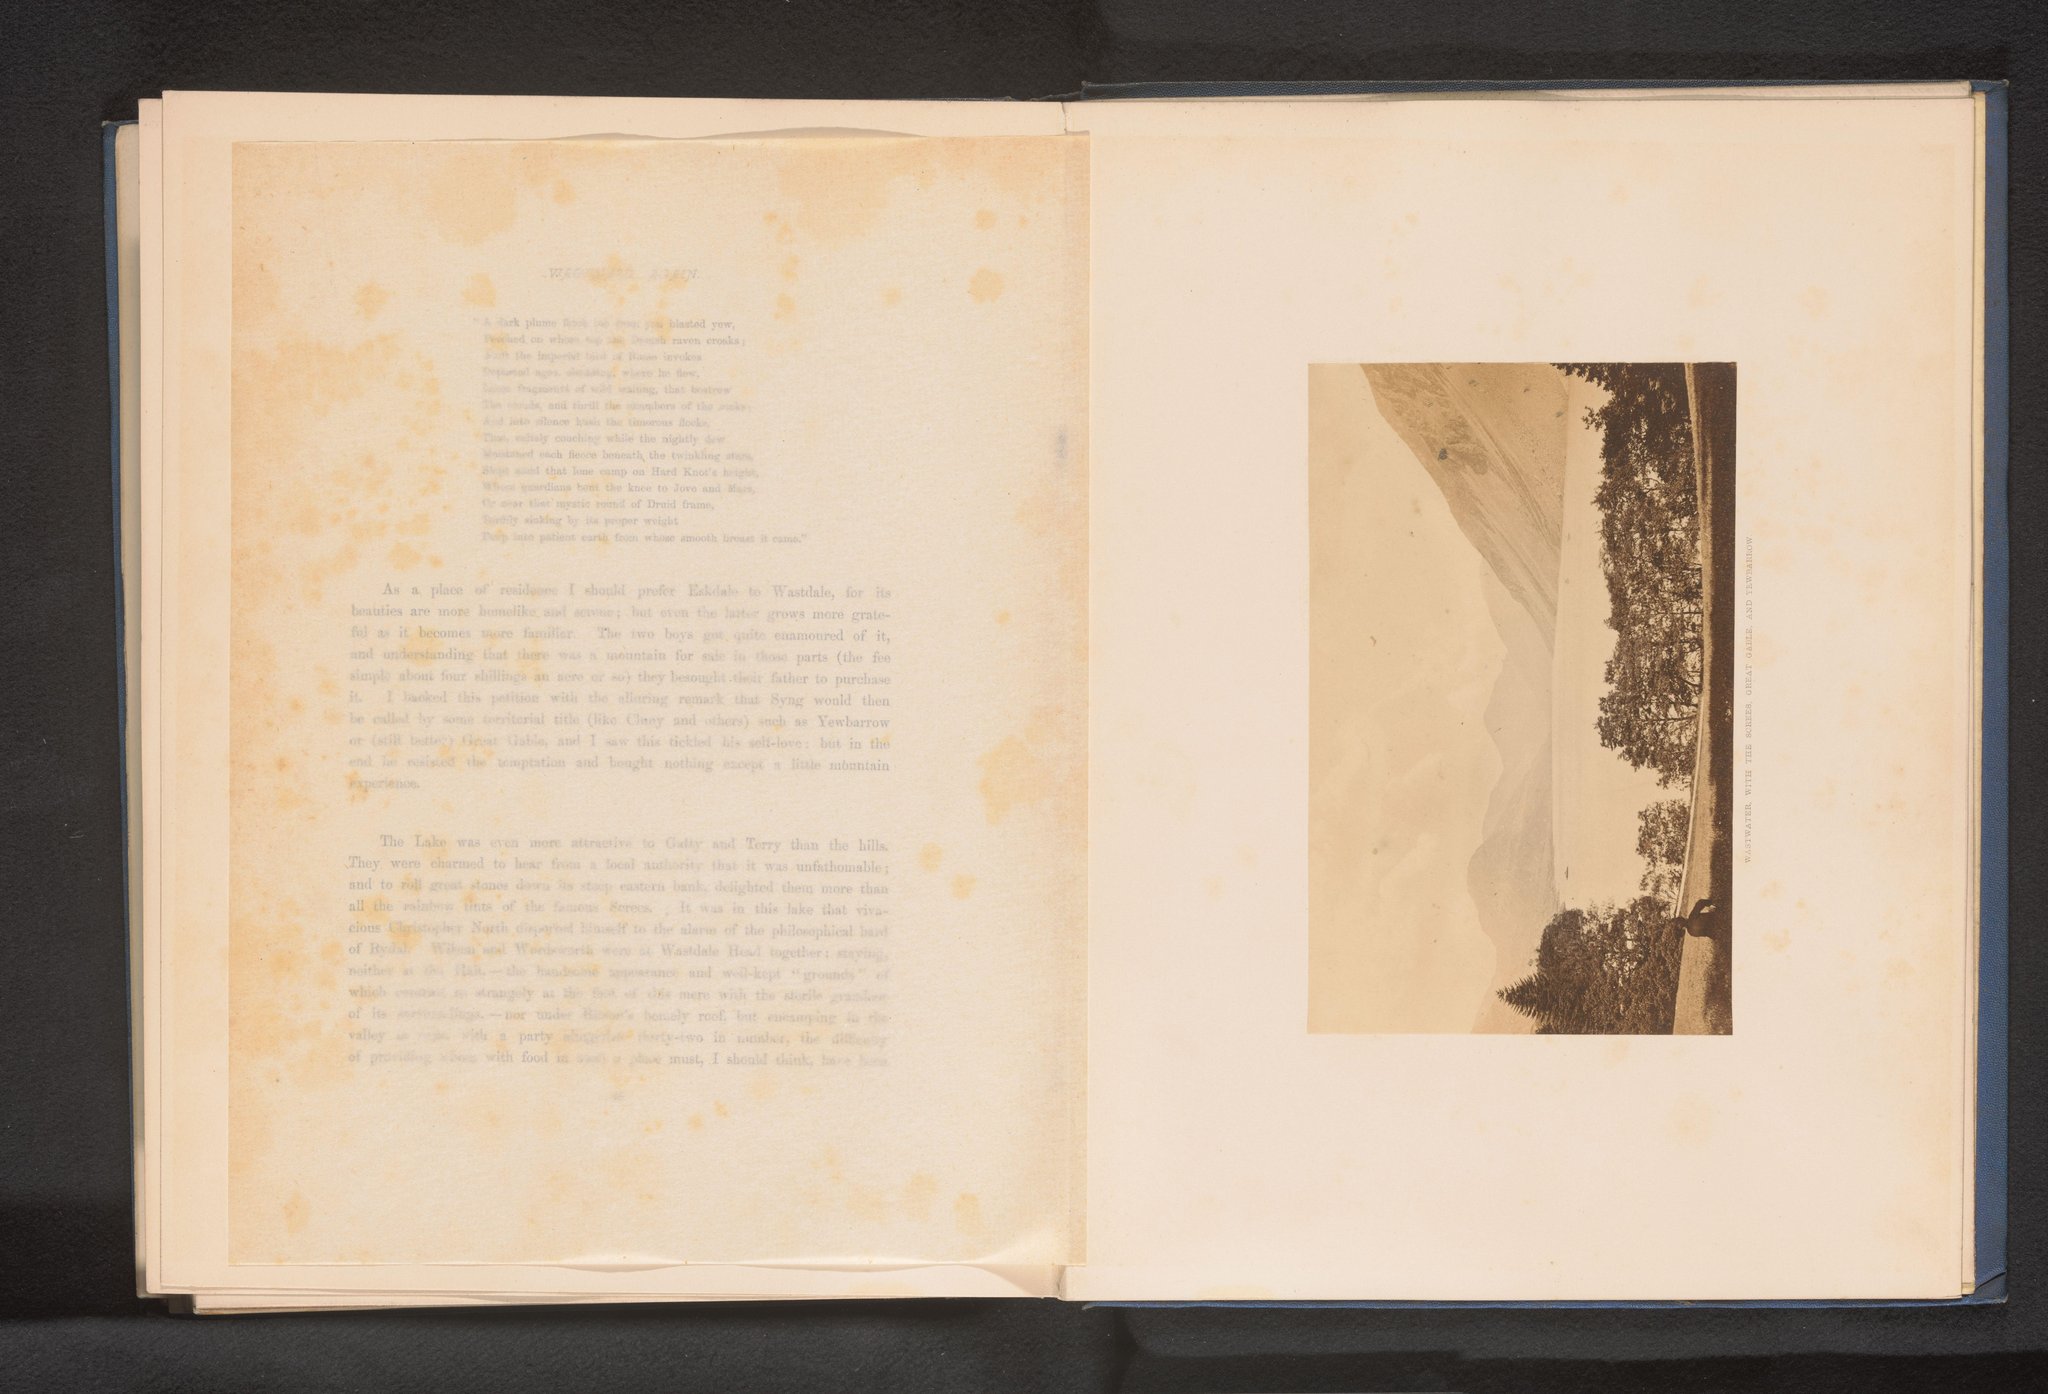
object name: page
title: Gezicht op Wast Water en bergen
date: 1857-1871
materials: photographic support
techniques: albumen print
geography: lake district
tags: lake, mountains